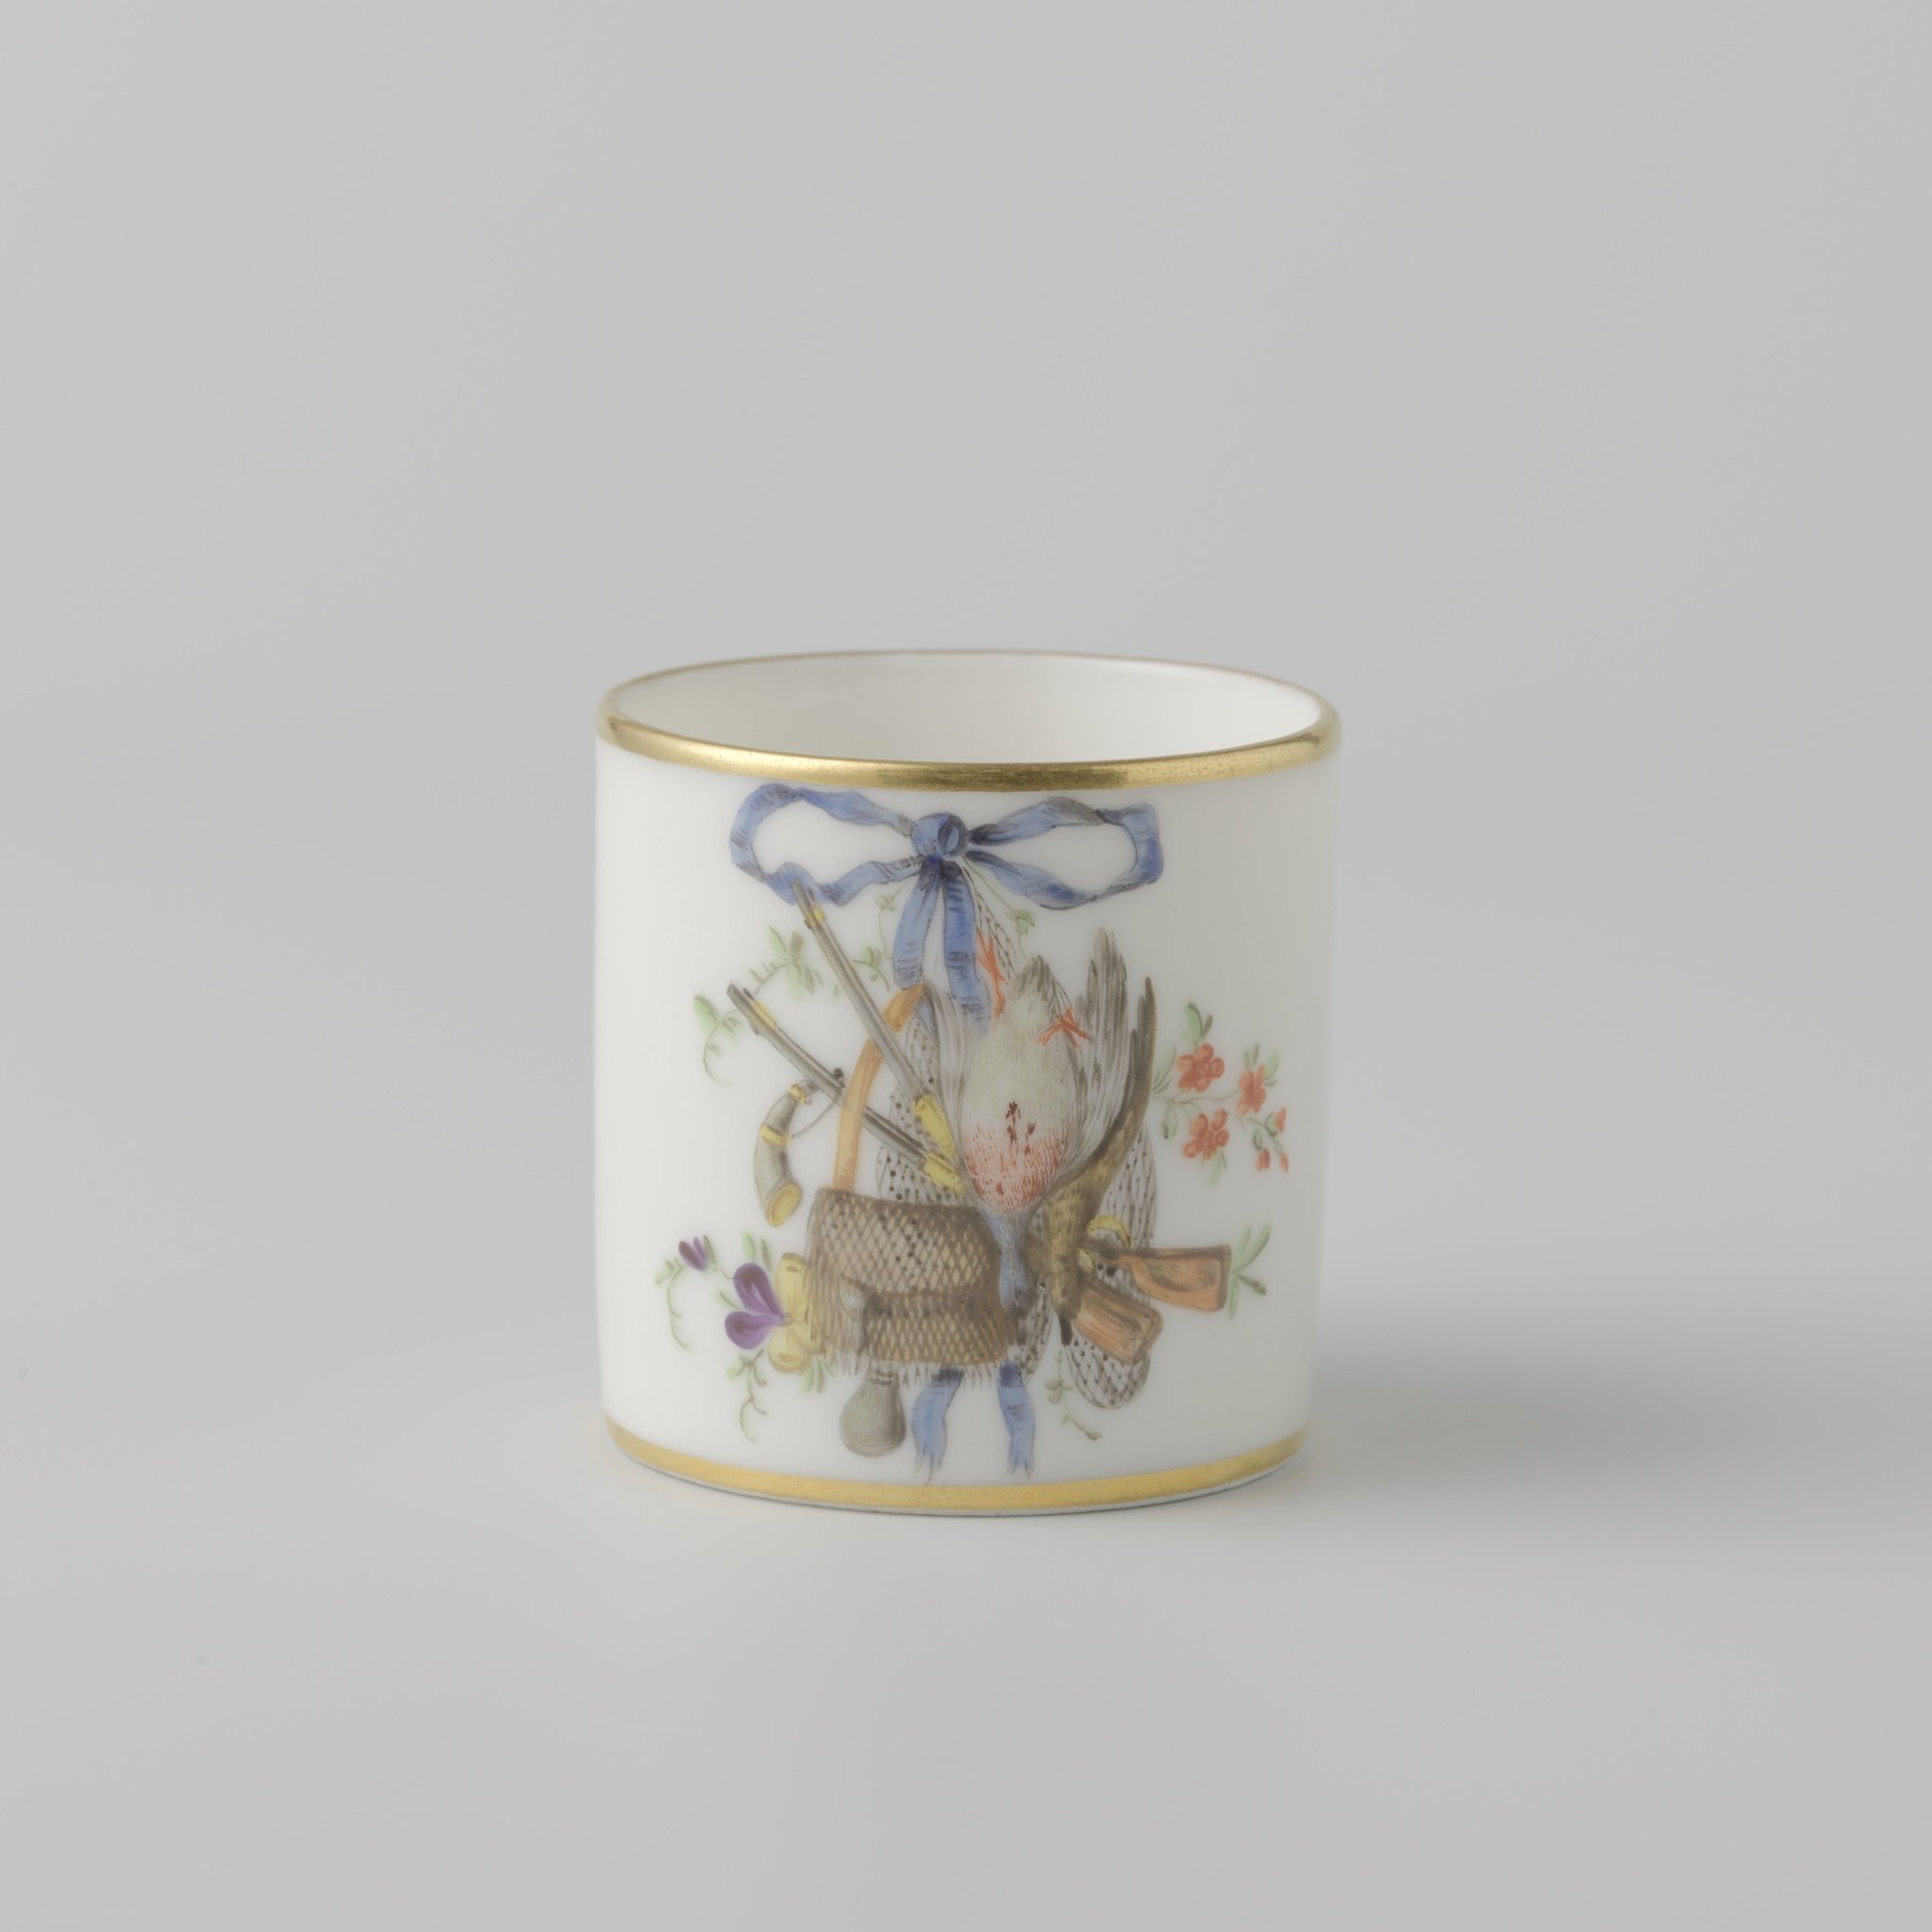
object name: tea cup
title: Theekop met decoratie van trofeeën aan gestrikte linten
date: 1809-1814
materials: porcelain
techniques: painted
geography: nieuwer-amstel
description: Theeservies bestaande uit een theepot, een suikerpot, een spoelkom en twaalf koppen en schotels veelkleurig beschilderd met trofeeën hangend aan blauwe strikken. De trofeeën hebben betrekking op diverse beroepen. Gemerkt in zwart: Amstel (de suikerpot Amstel N. 805 en ingegrift A). Verschillende ingegrifte merken in de koppen en schotels.